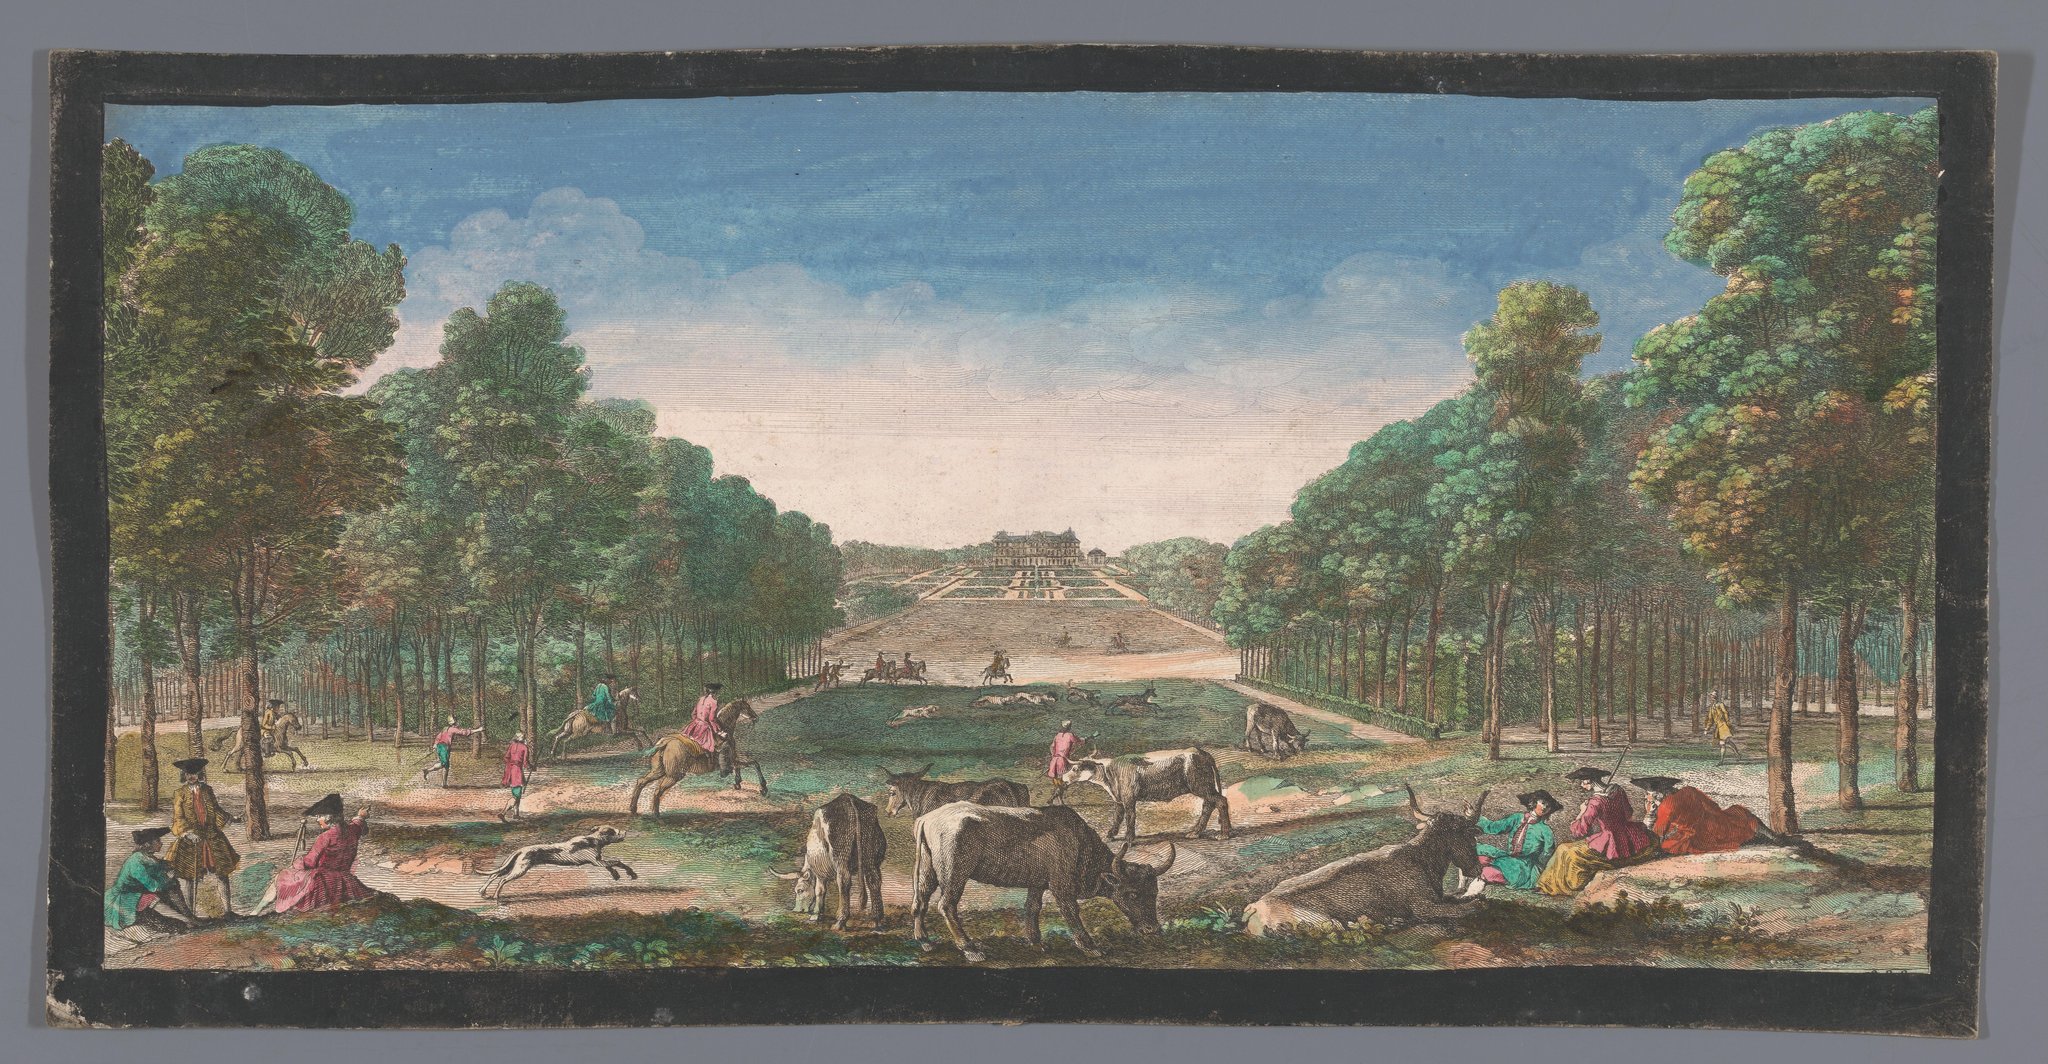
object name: print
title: Gezicht op de tuin van het Château de Sceaux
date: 1700-1799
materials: cardboard, paper, watercolor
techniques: brush, etching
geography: paris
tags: hunting, chase, garden, ornamental plants, civic architecture; edifices; dwellings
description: Op de voorgrond een hertenjacht met ruiters en jachthonden. Op de achtergrond het Château de Sceaux.